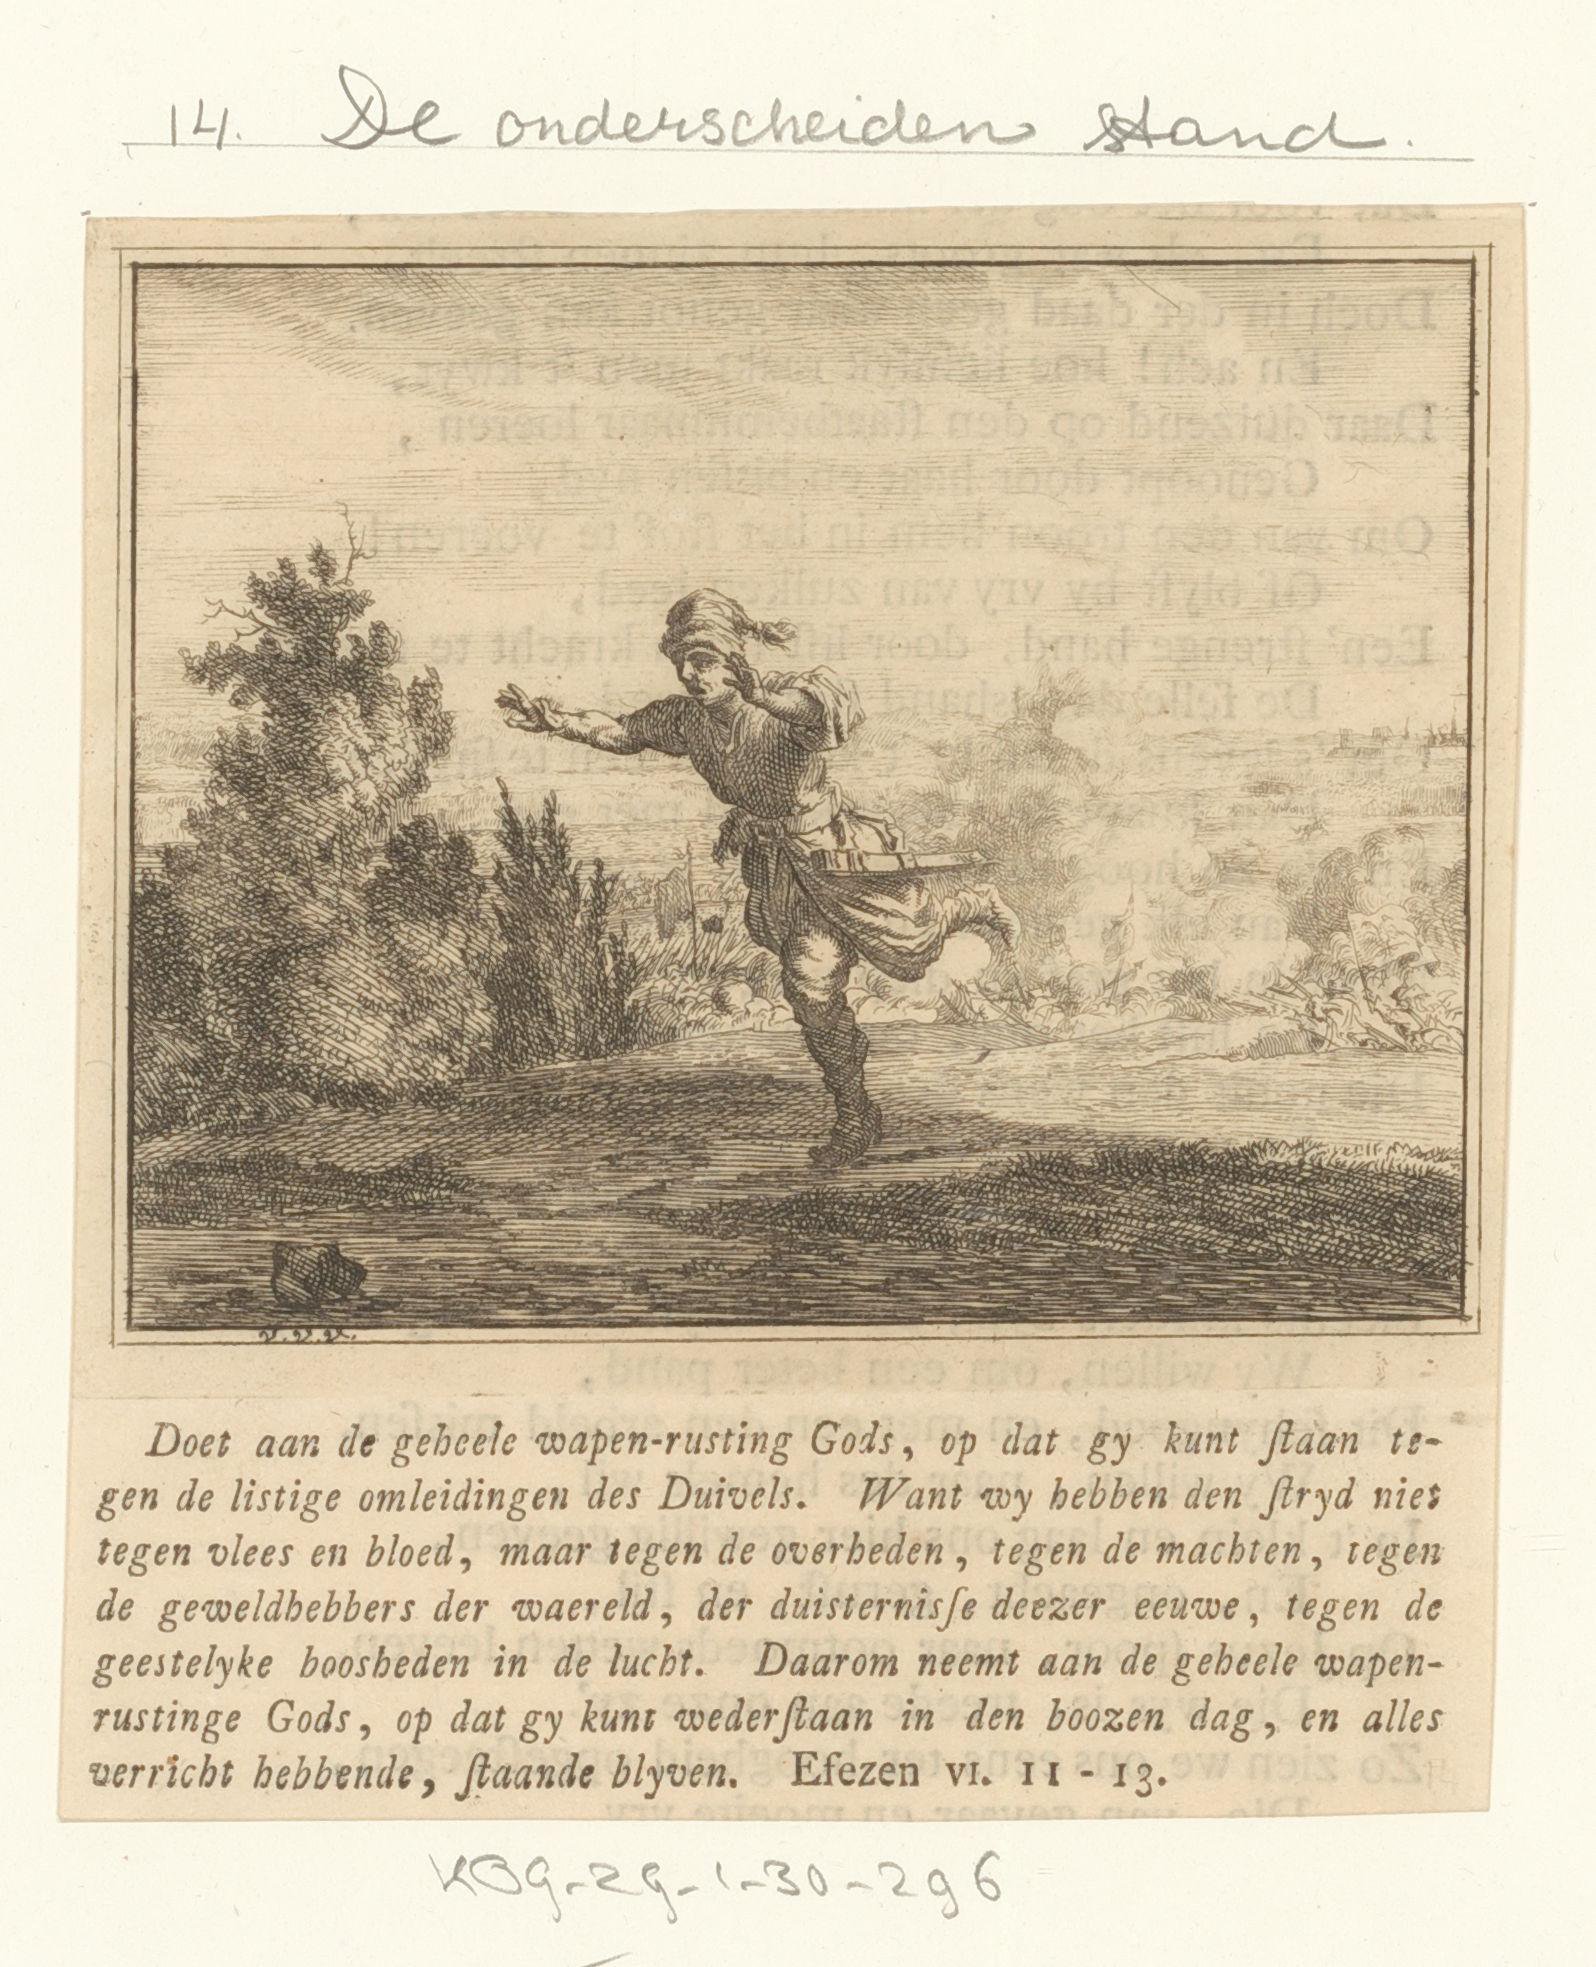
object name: print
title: Man vlucht weg bij het slagveld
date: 1758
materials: paper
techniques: etching, letterpress printing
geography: haarlem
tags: battle, flight, running away; pursuing, proverbs, sayings, etc.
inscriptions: collector's mark: Lugt 1641, stamp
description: Embleem bij het motto: De onderscheiden Stand. Onderaan een zevenregelige tekst in het Nederlands. Onderwerpsrubrieken binnen de Atlas Zeden en Gewoonten: Zeden en Gewoonten in engeren zin. Volksleven. Zinnebeeldige voorstellingen uit het volkleven op serieprenten. Maanden en diversen (allegorieën).